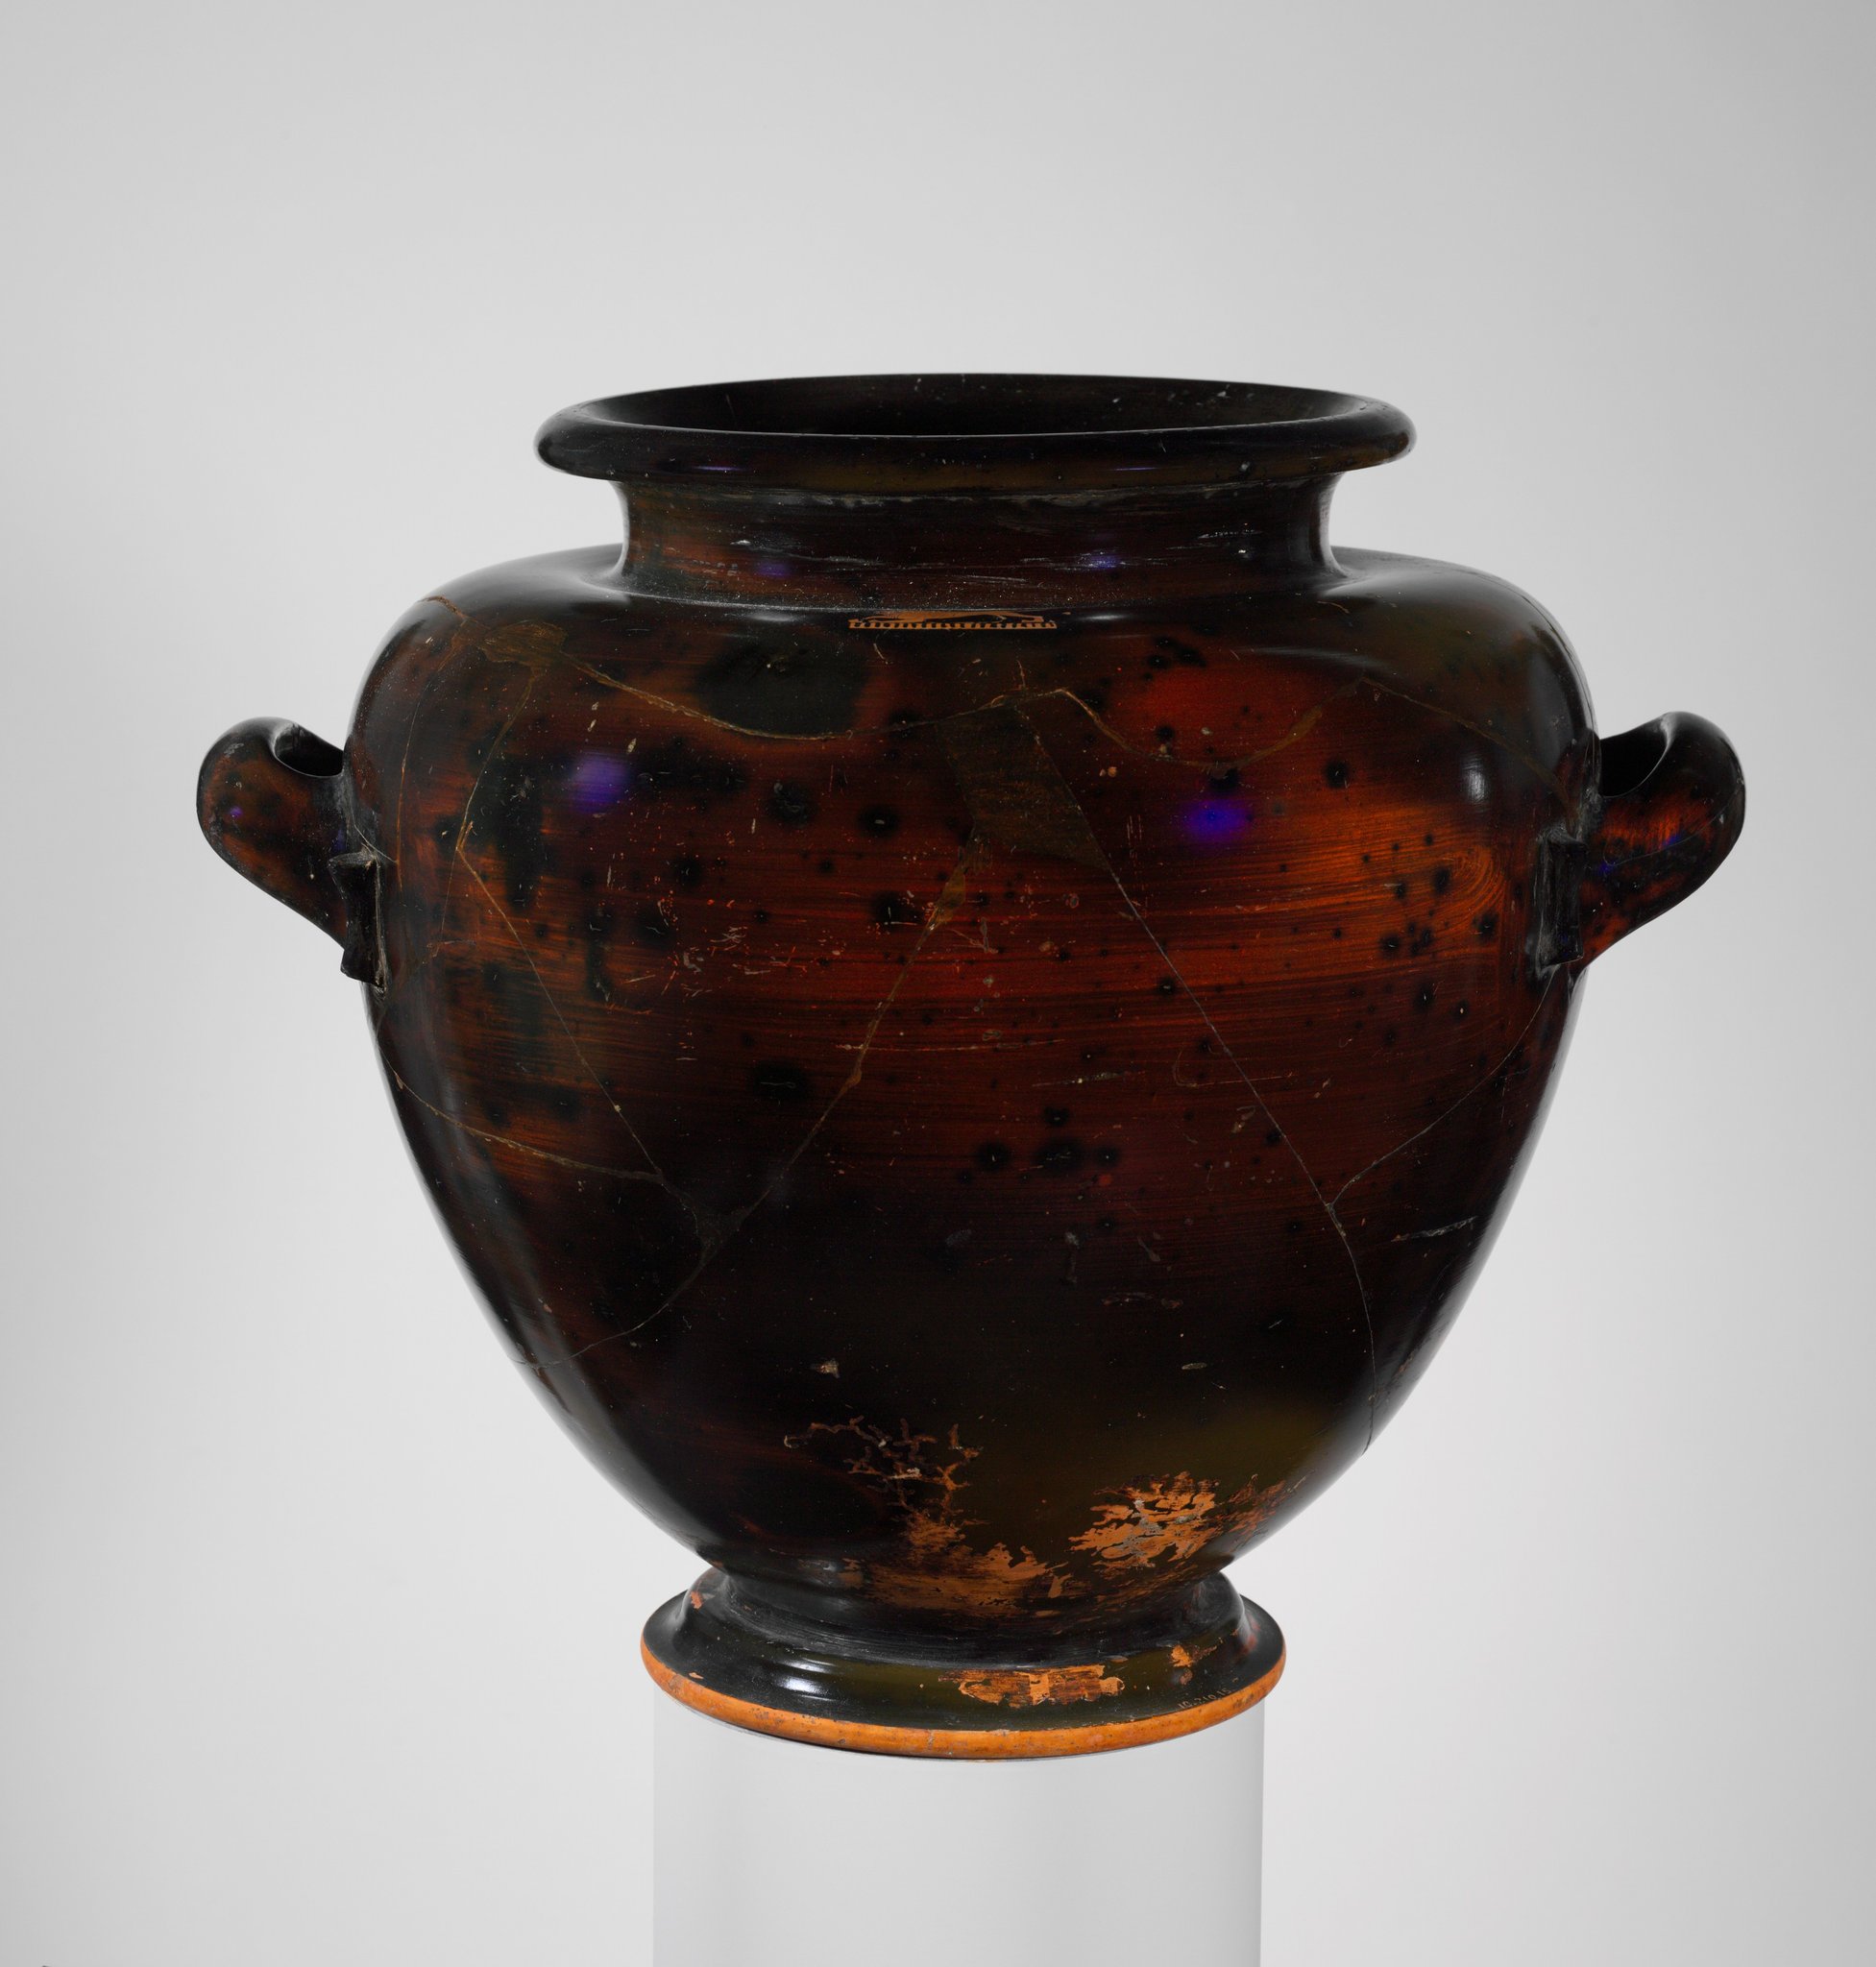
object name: stamnos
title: Terracotta stamnos (jar)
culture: greek, attic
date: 500-468 BCE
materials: terracotta